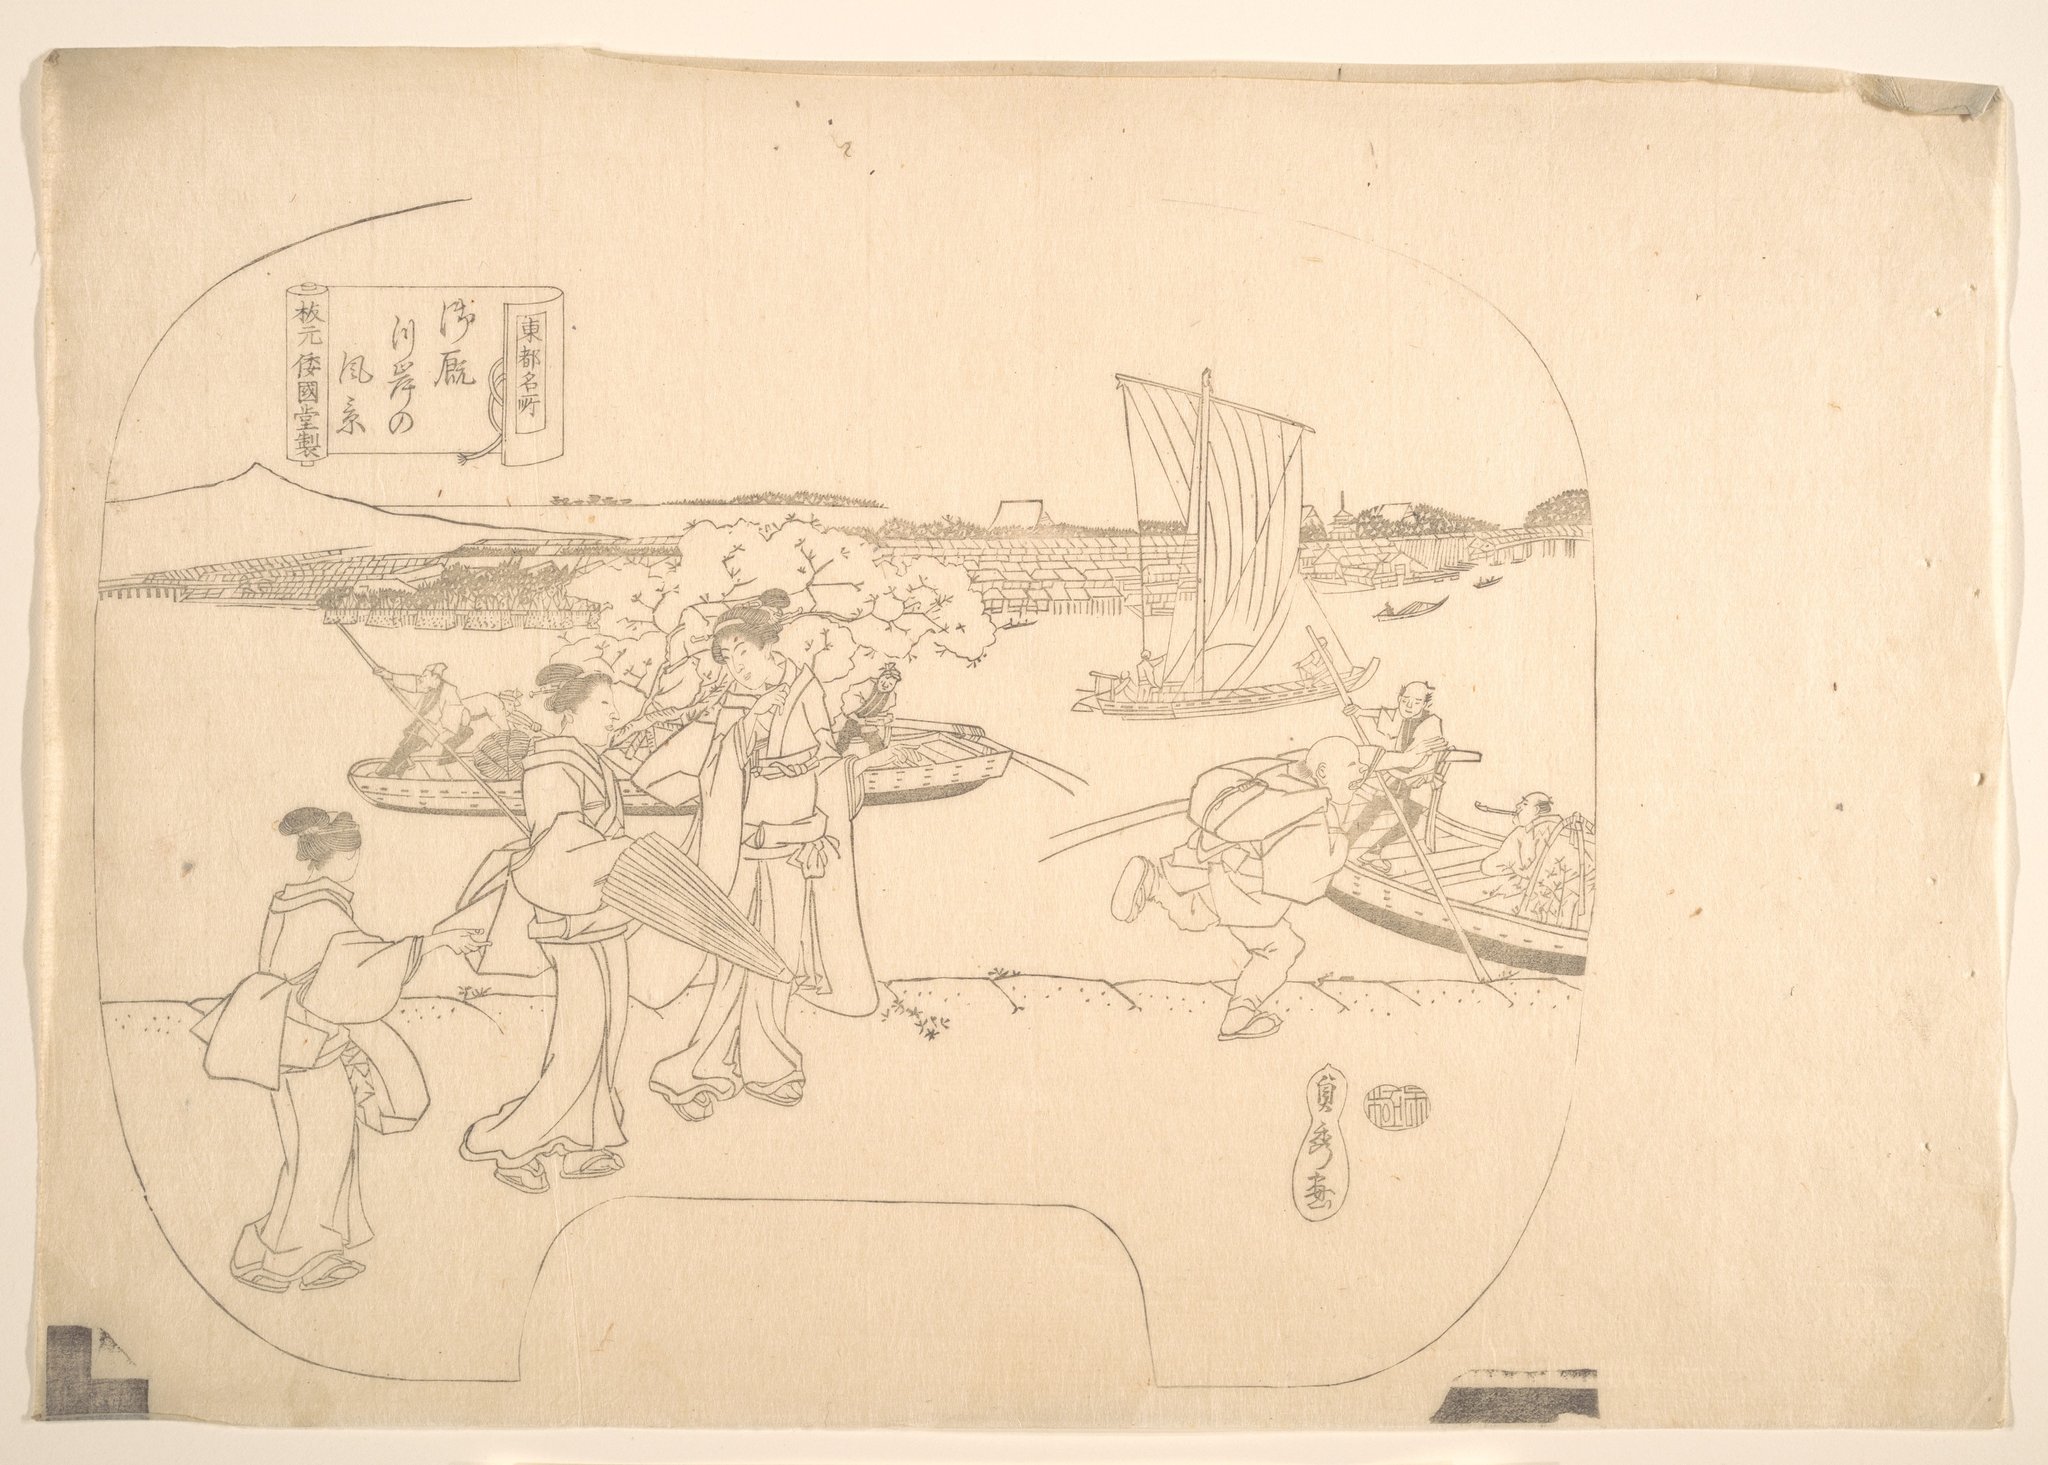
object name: print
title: Proof Line-Block Print for Fan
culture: japanese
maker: utagawa (gountei) sadahide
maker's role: artist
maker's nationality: japanese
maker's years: 1807-1873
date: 1801-1900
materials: ink, paper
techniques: line block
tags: men,women,boats